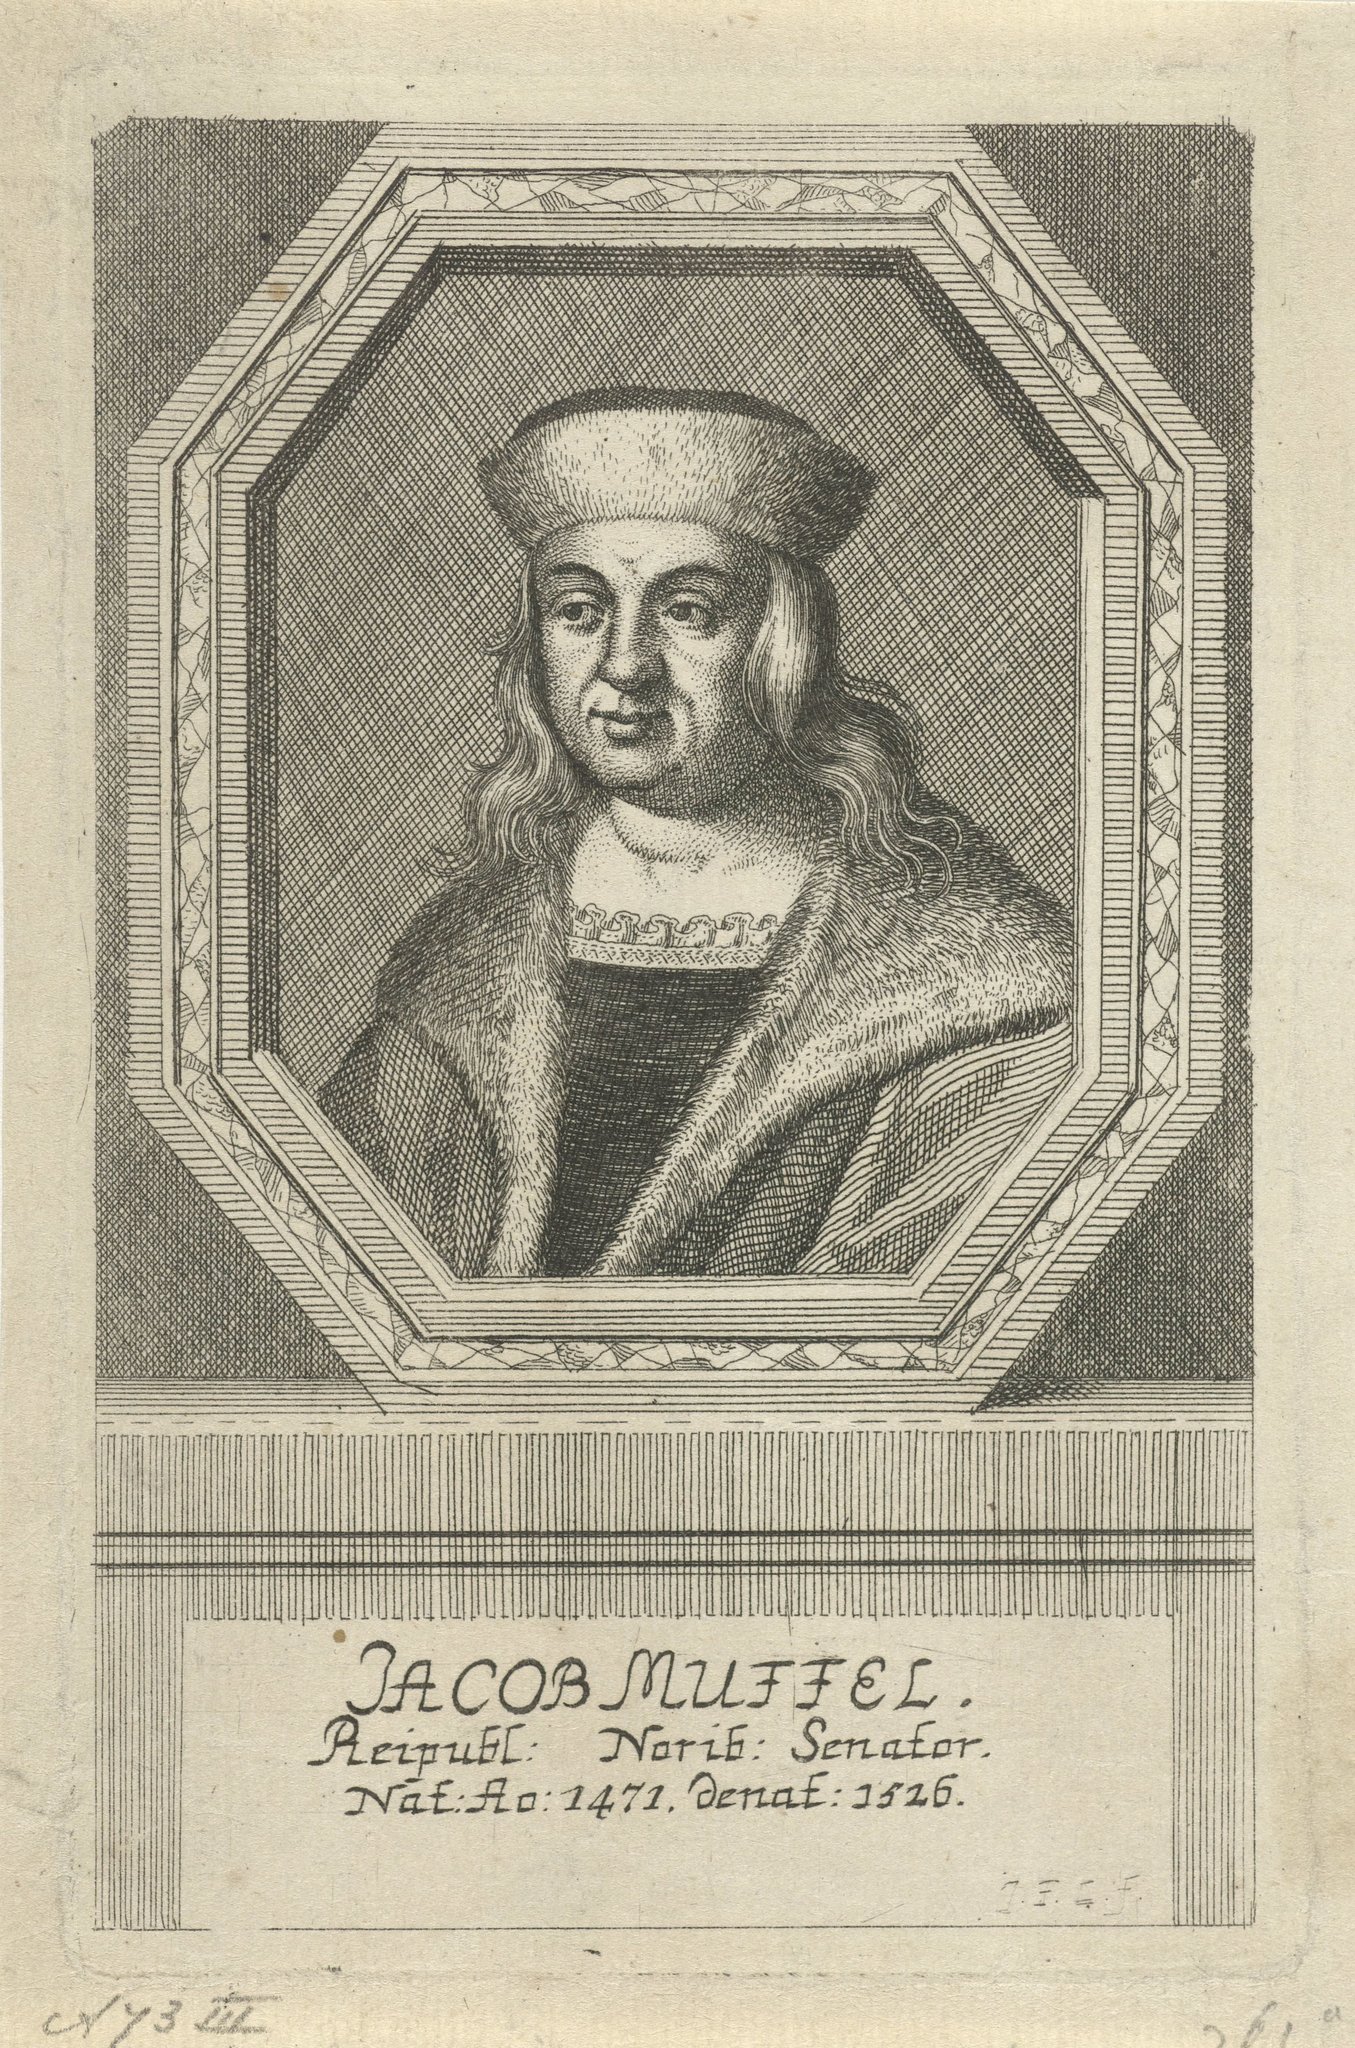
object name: print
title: Portret van Jacob Muffel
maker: johann friedrich leonard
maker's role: print maker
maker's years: 1633-1680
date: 1643-1680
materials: paper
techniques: engraving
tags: jacob muffel (1471-1526)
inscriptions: collector's mark: Lugt 2228, collector's mark: Lugt 1337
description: Portret van Jacob Muffel (1471-1526), senator te Neurenberg.